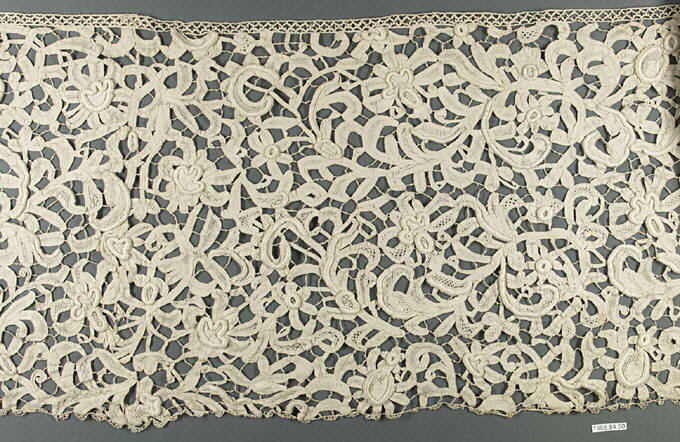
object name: flounce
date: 1667-1700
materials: linen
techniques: lace